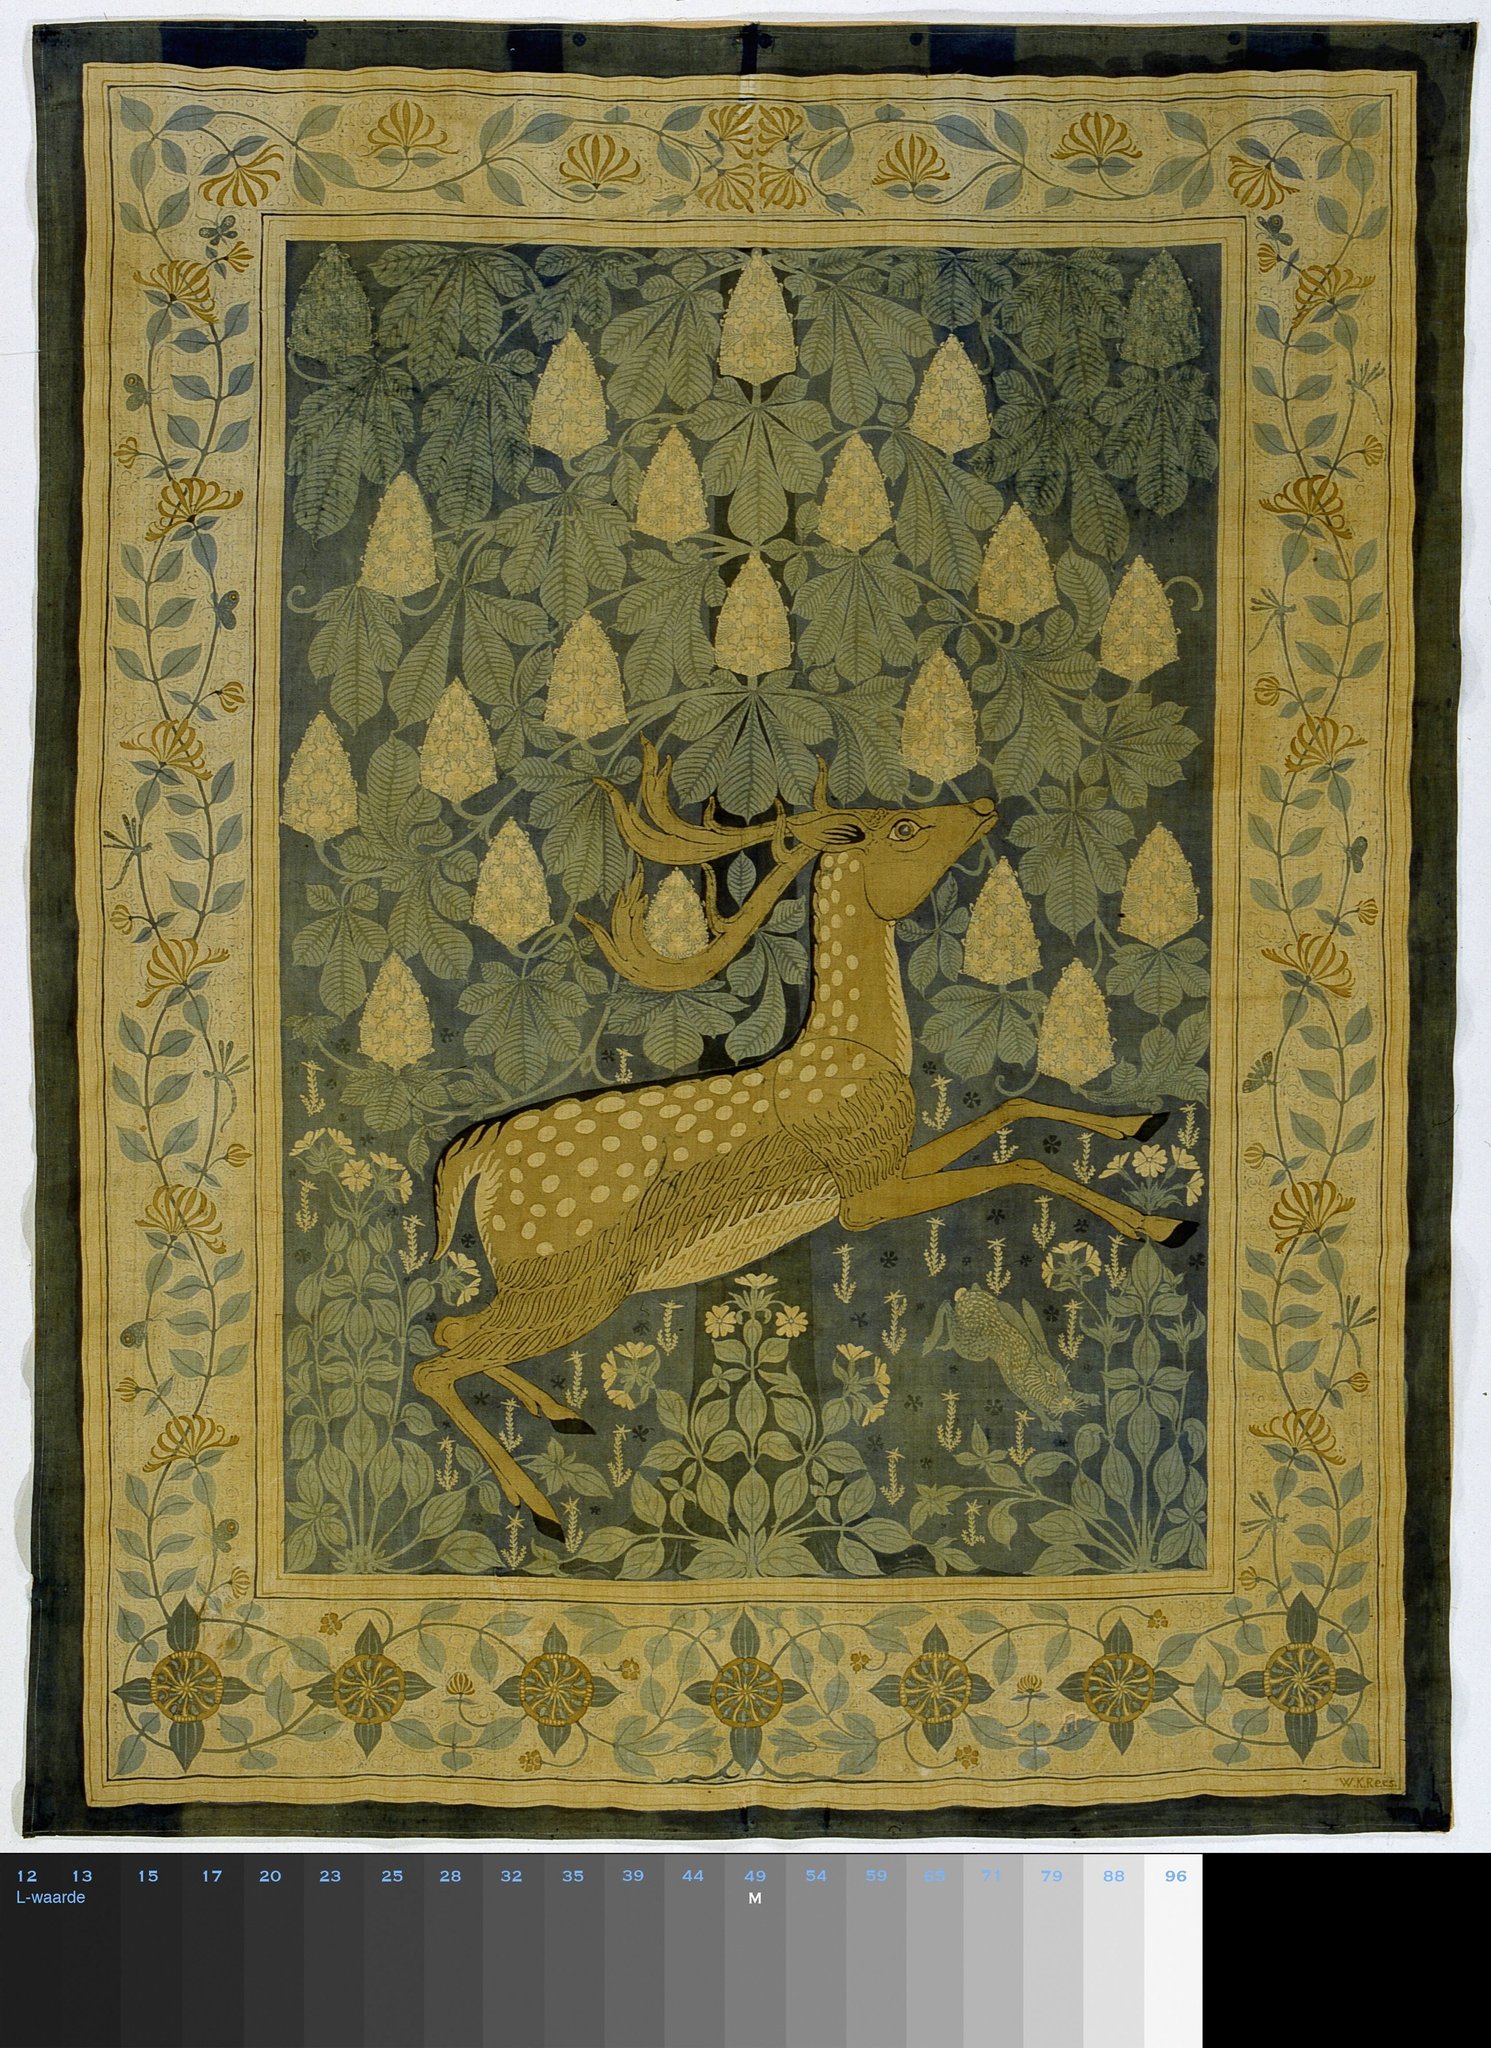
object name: tapestry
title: Wandkleed met springend hert tegen een achtergrond van bloeiende kastanjes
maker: willem karel rees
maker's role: designer, painter, print maker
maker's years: 1880-1962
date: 1902-1909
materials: cotton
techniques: batik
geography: haarlem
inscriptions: signature: ‘W.K. Rees’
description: Gebatikt linnen kleed in blauwgroen, blauw en bruingeel op een ecru fond. Voorstelling: bloeiende kastanje waaronder een damhert en een konijn tussen bloeiende wilde planten (floxen, muurpeper). Langs de buitenzijde een brede rand van kamperfoelie met libelles en vlinders. Gesigneerd.